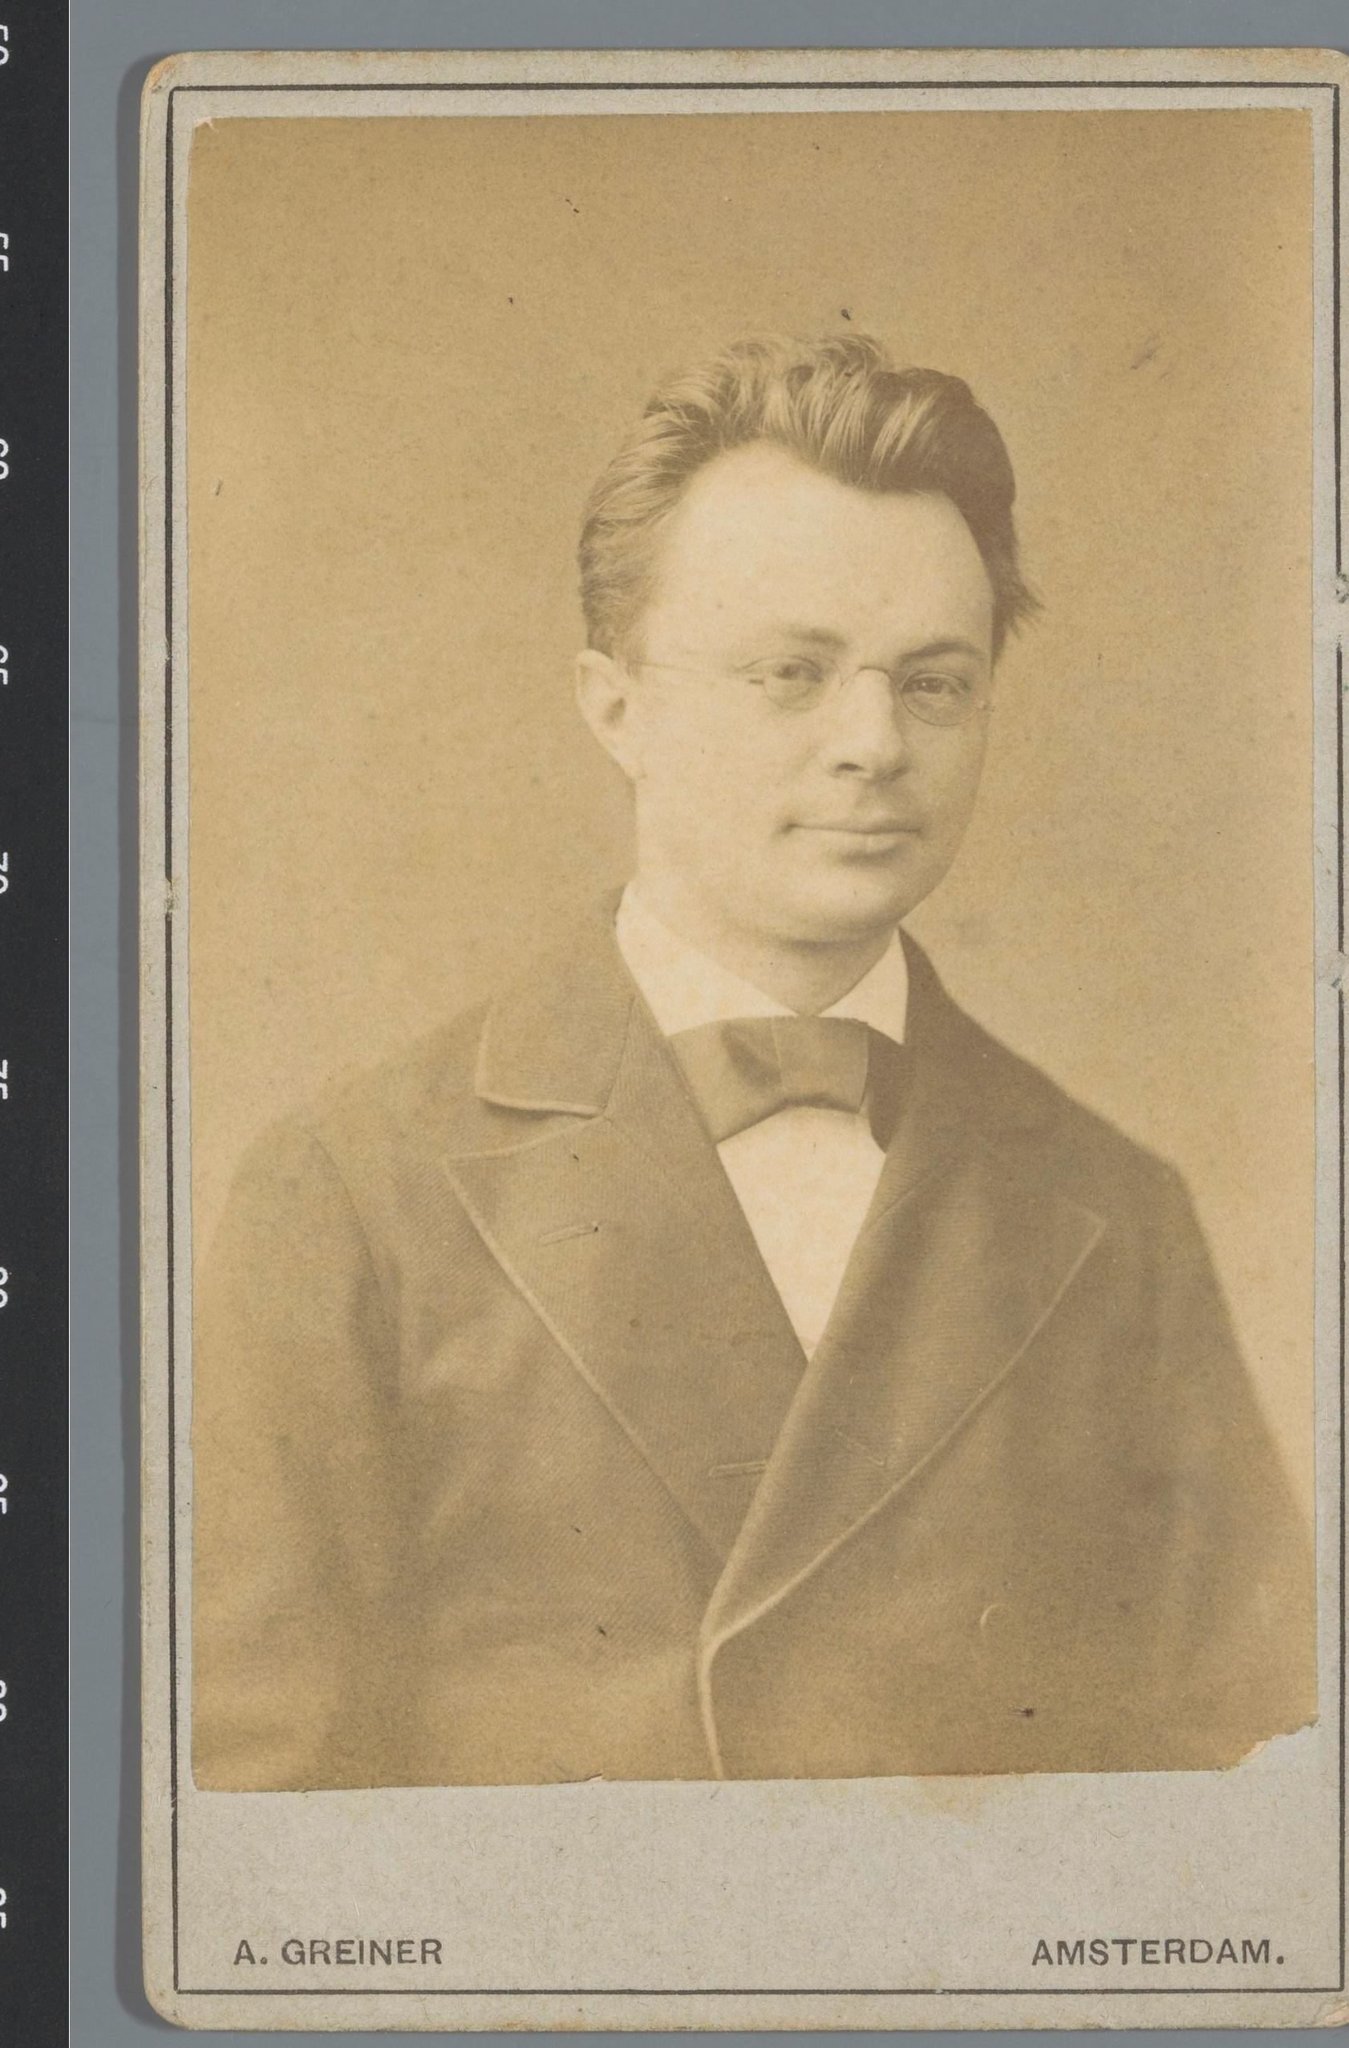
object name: carte de visite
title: Portret van een onbekende man met bril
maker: albert greiner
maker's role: fotograaf, fotostudio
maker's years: 1833-1890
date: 1874-1887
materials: cardboard, paper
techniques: albumen print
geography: amsterdam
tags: eyeglasses, spectacles, adult man, historical persons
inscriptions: inscription: ‘A. GREINER/ PHOTOGRAAF/ van/ H.H.M.M. DEN KONING EN DE KONINGIN/ der/ Nederlanden/ NIEUWENDIJK L. 89./ AMSTERDAM./ SPECIALITEIT IN VERGROOTINGEN./ Ferd. Beyrich, Berlin.’, inscription: ‘[...]’